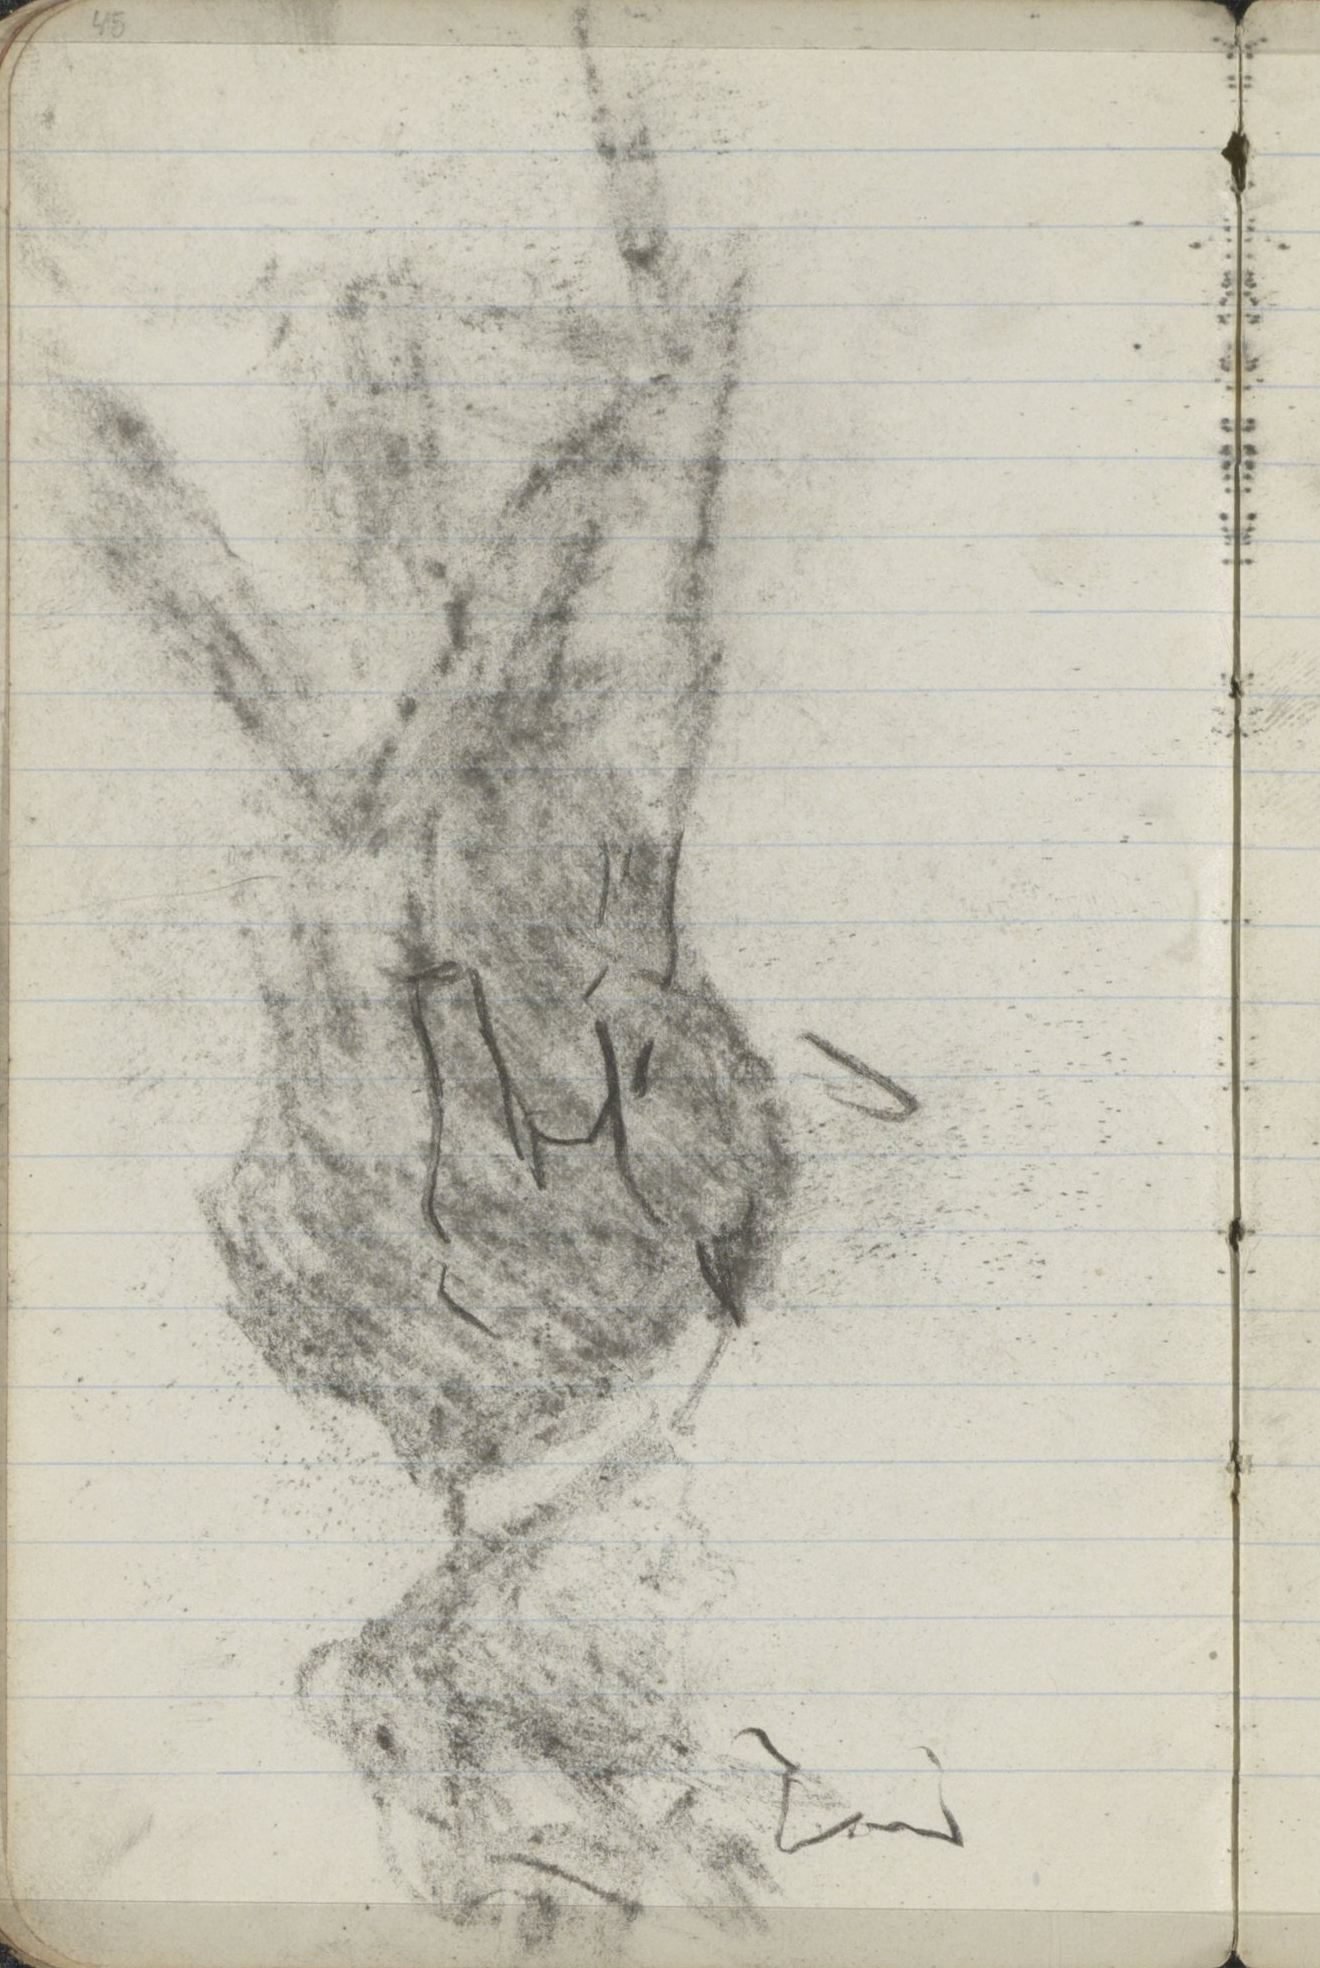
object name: sketchbook leaf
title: Studieblad, mogelijk met katten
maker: george hendrik breitner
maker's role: draughtsman, painter, print maker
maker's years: 1857-1923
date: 1894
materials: chalk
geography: amsterdam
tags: cat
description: Pagina 45 uit een schetsboek met 31 bladen.